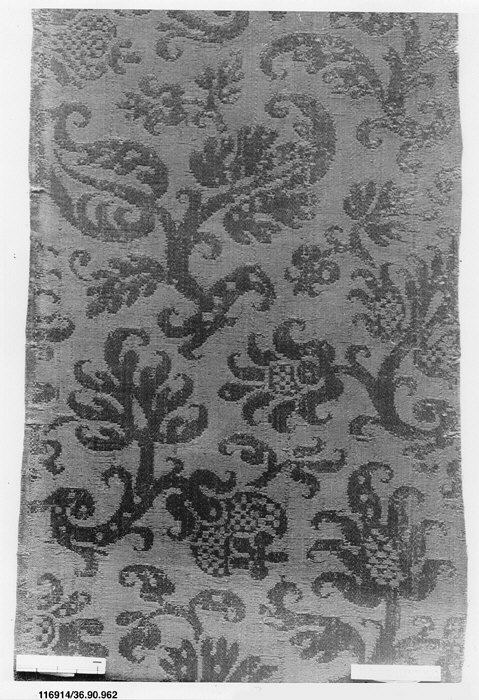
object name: piece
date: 1601-1700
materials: silk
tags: leaves